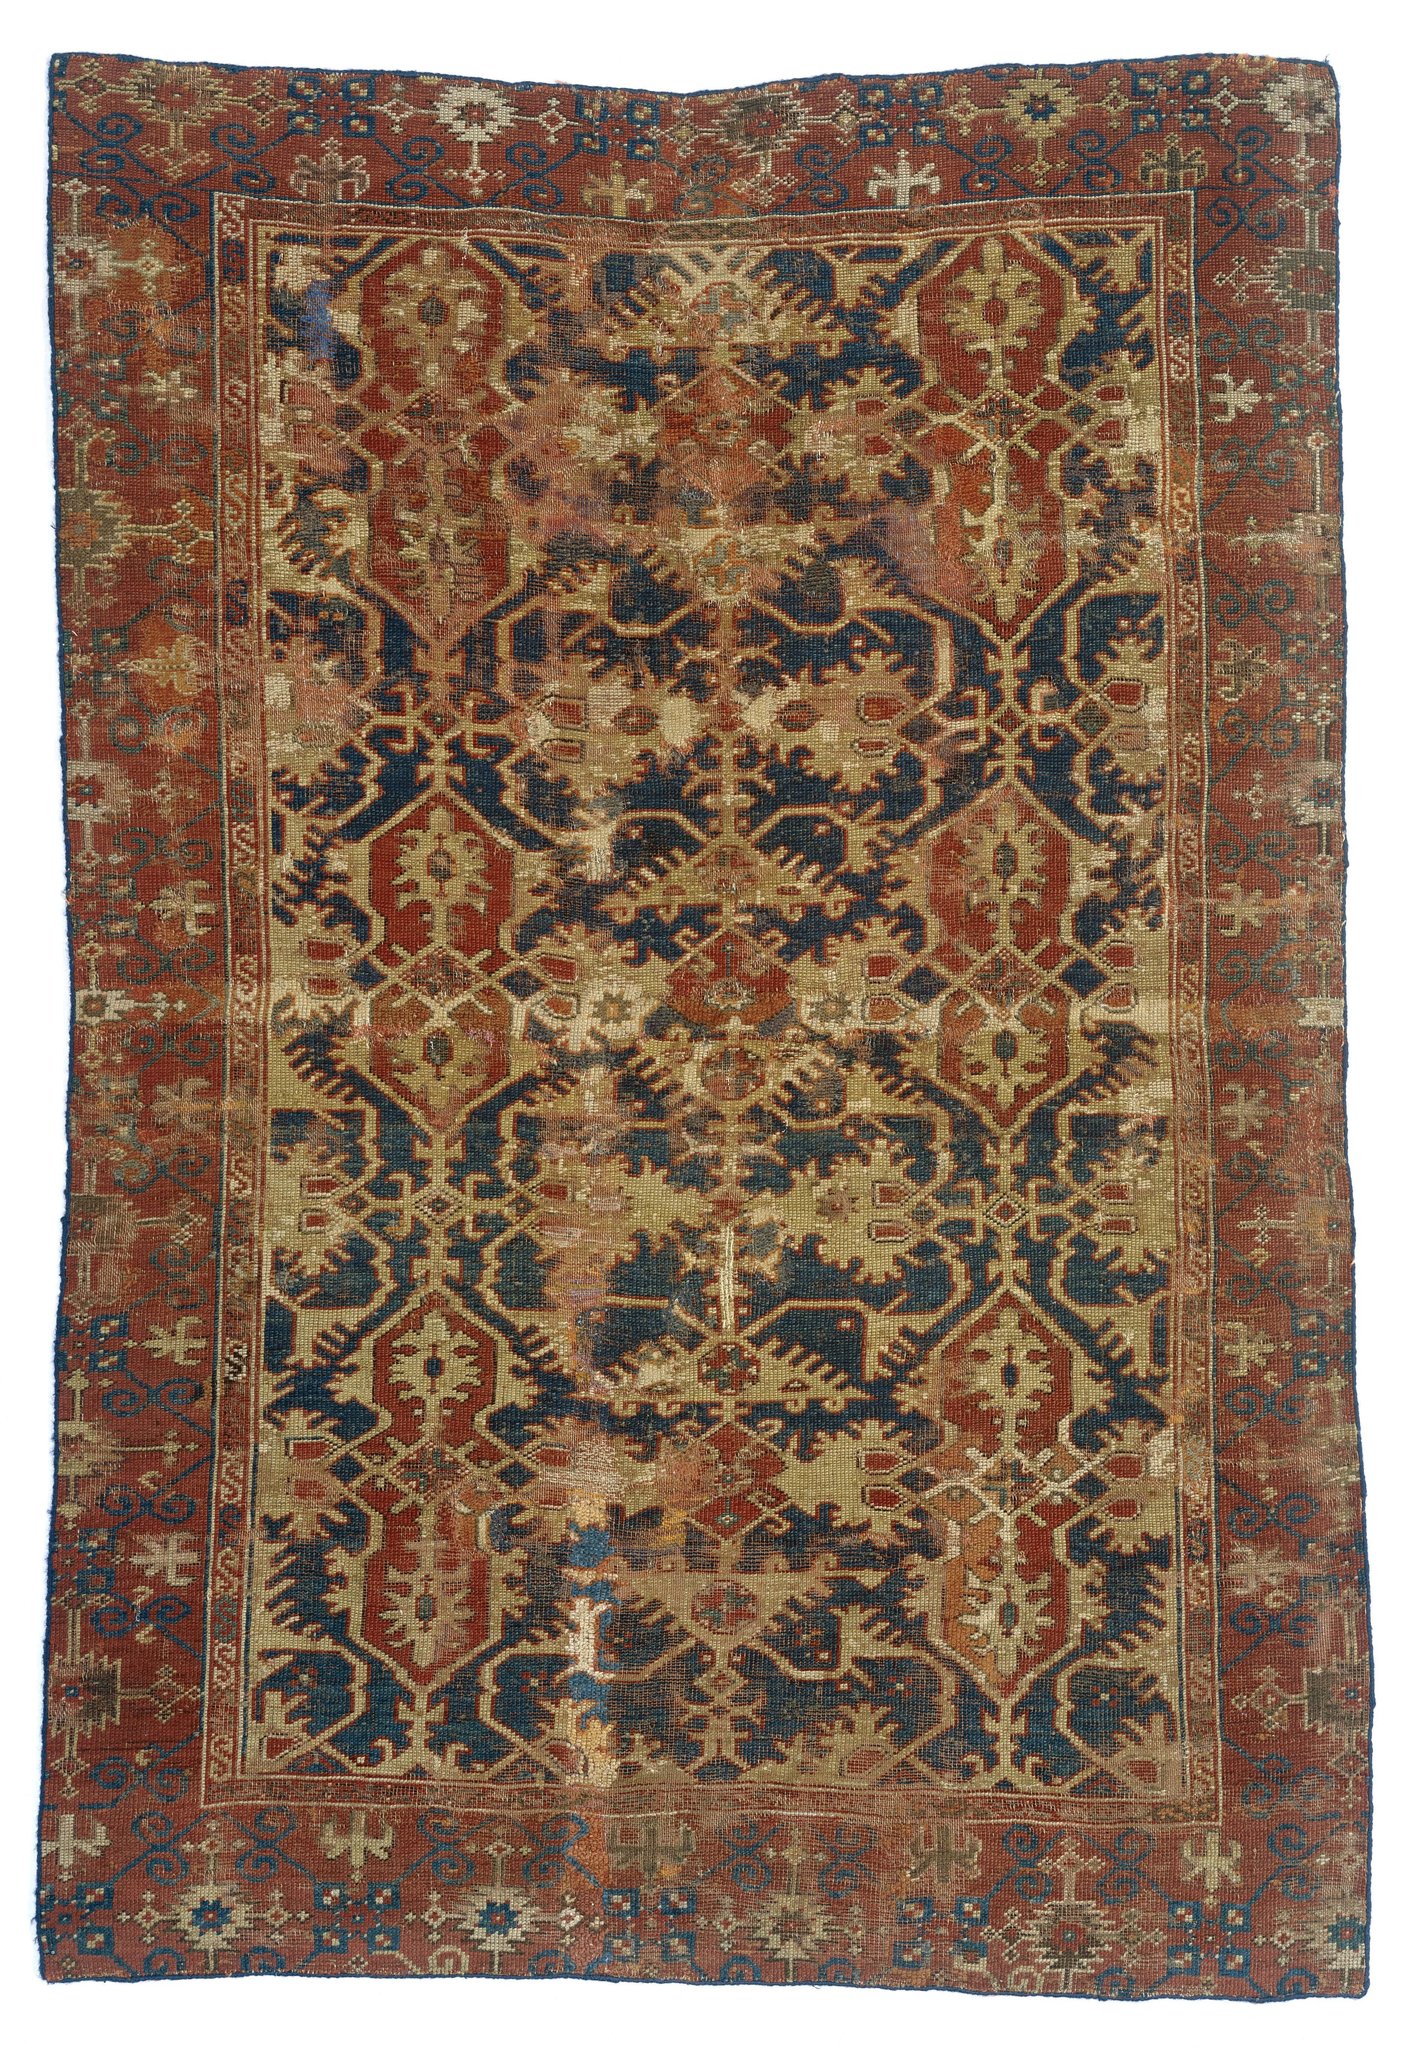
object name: oriental rug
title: Oosters tapijt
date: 1600-1699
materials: wool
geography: usak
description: Oosters tapijt, arabeskenkleed, lottotapijt. Middenveld met fletsgele arabesken op een kobaltblauwe grond. Tweevoudige rand, waarvan de breedste met kruisende ranken. Knoop: Ghiordes knoop.